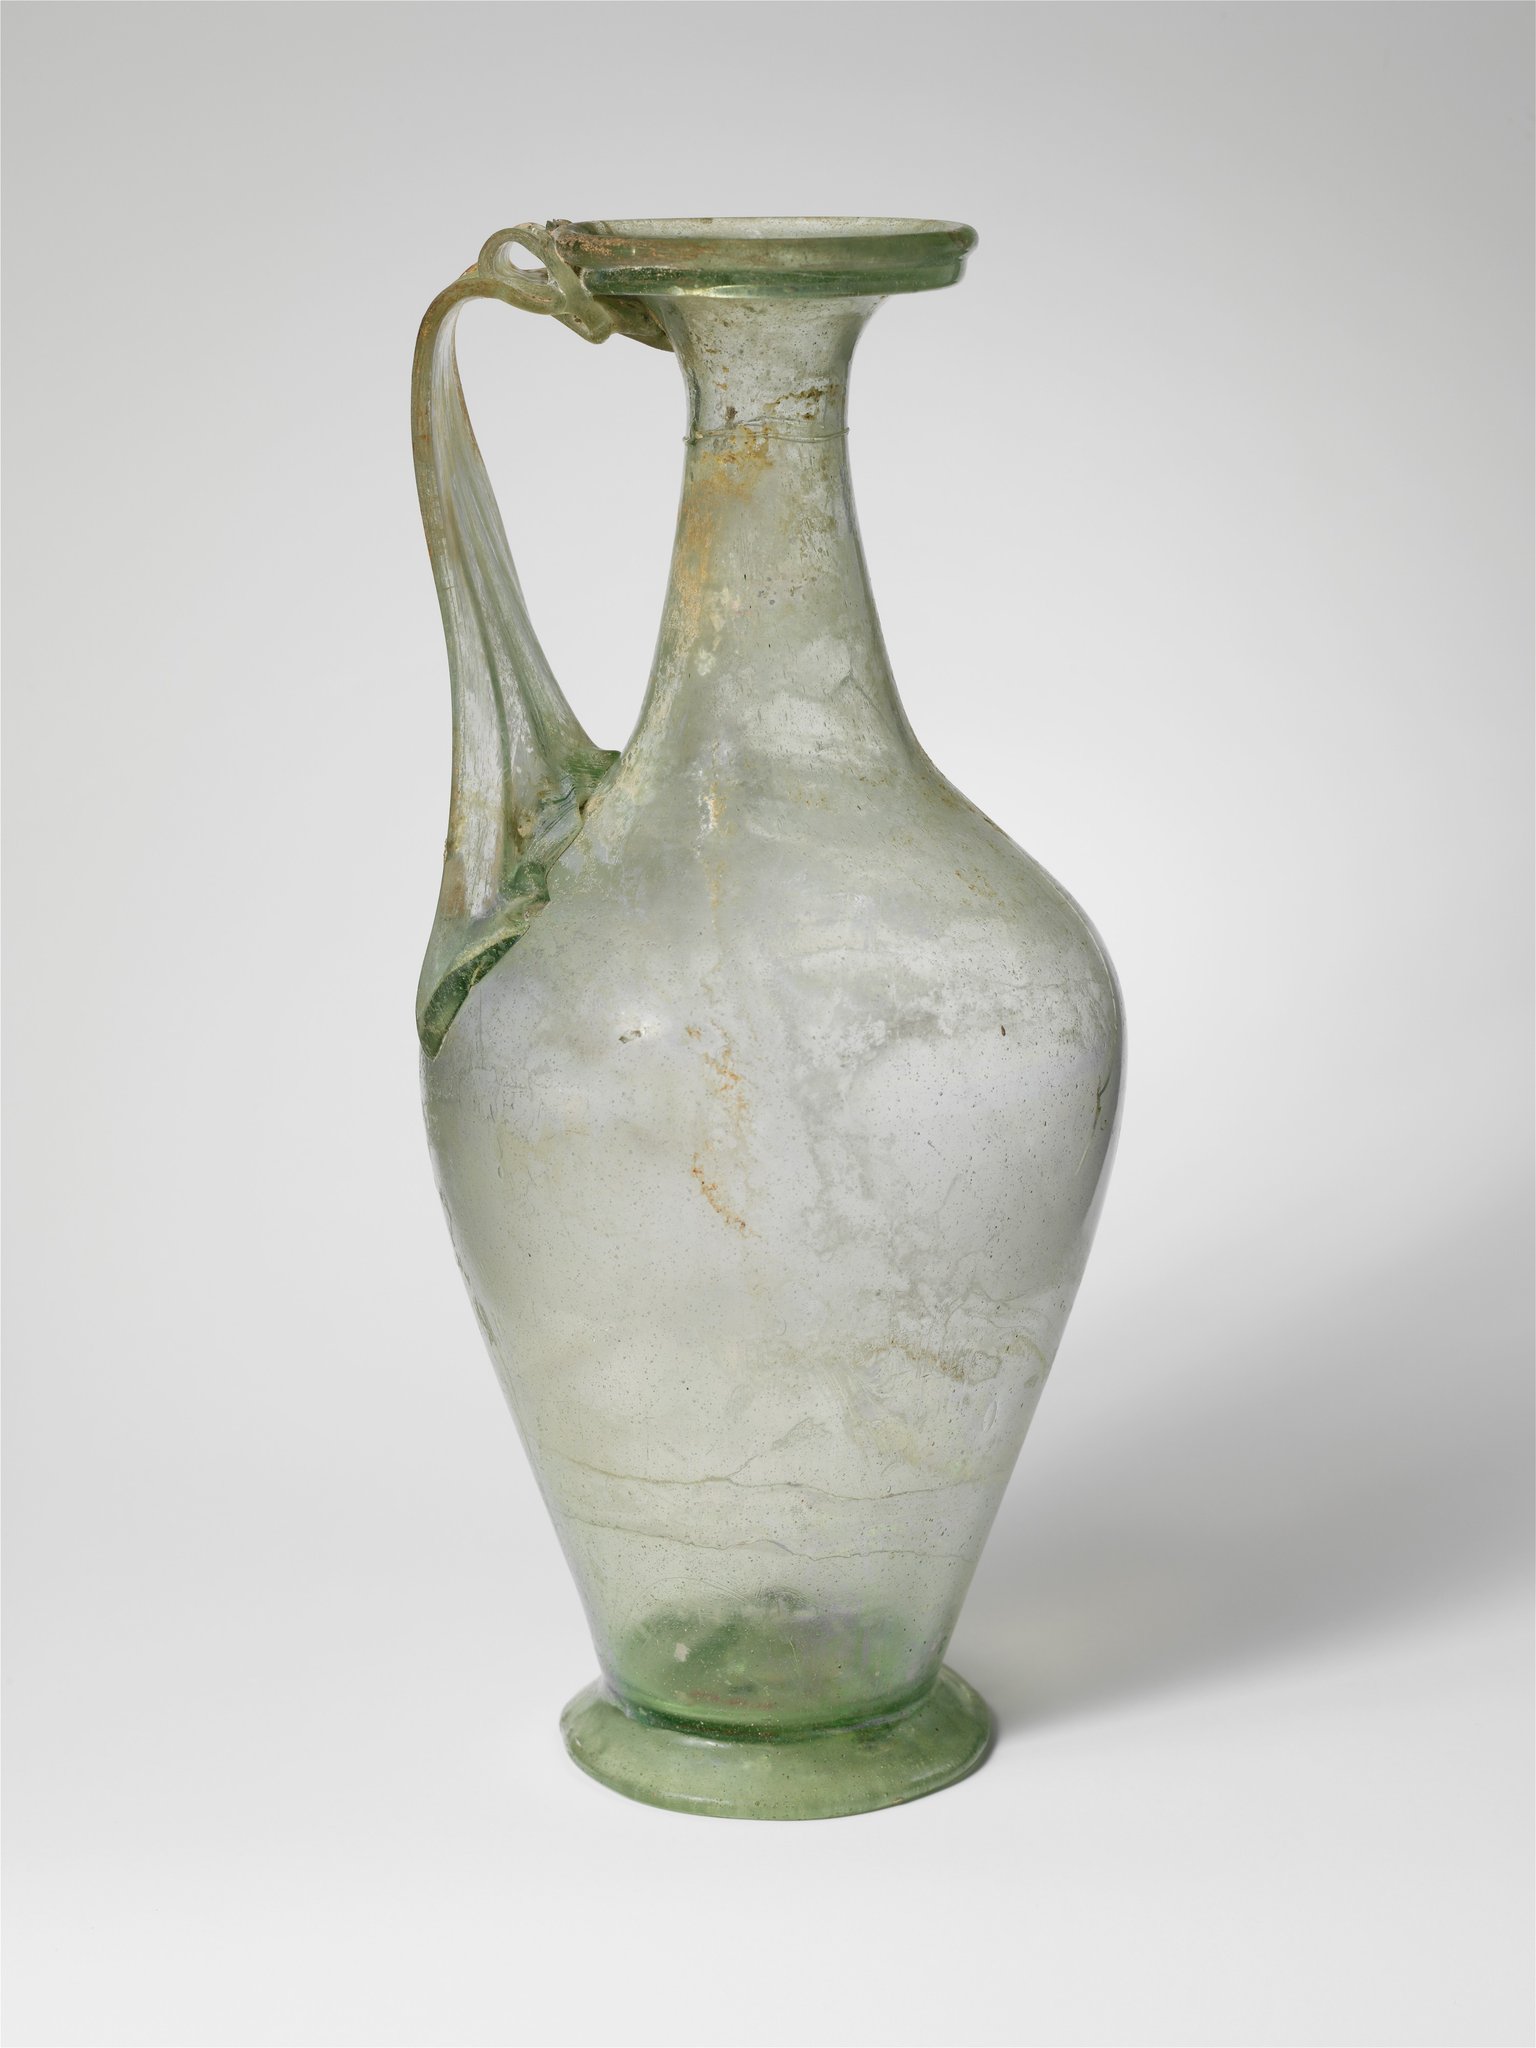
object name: jug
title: Glass jug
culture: roman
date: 267-333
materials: glass